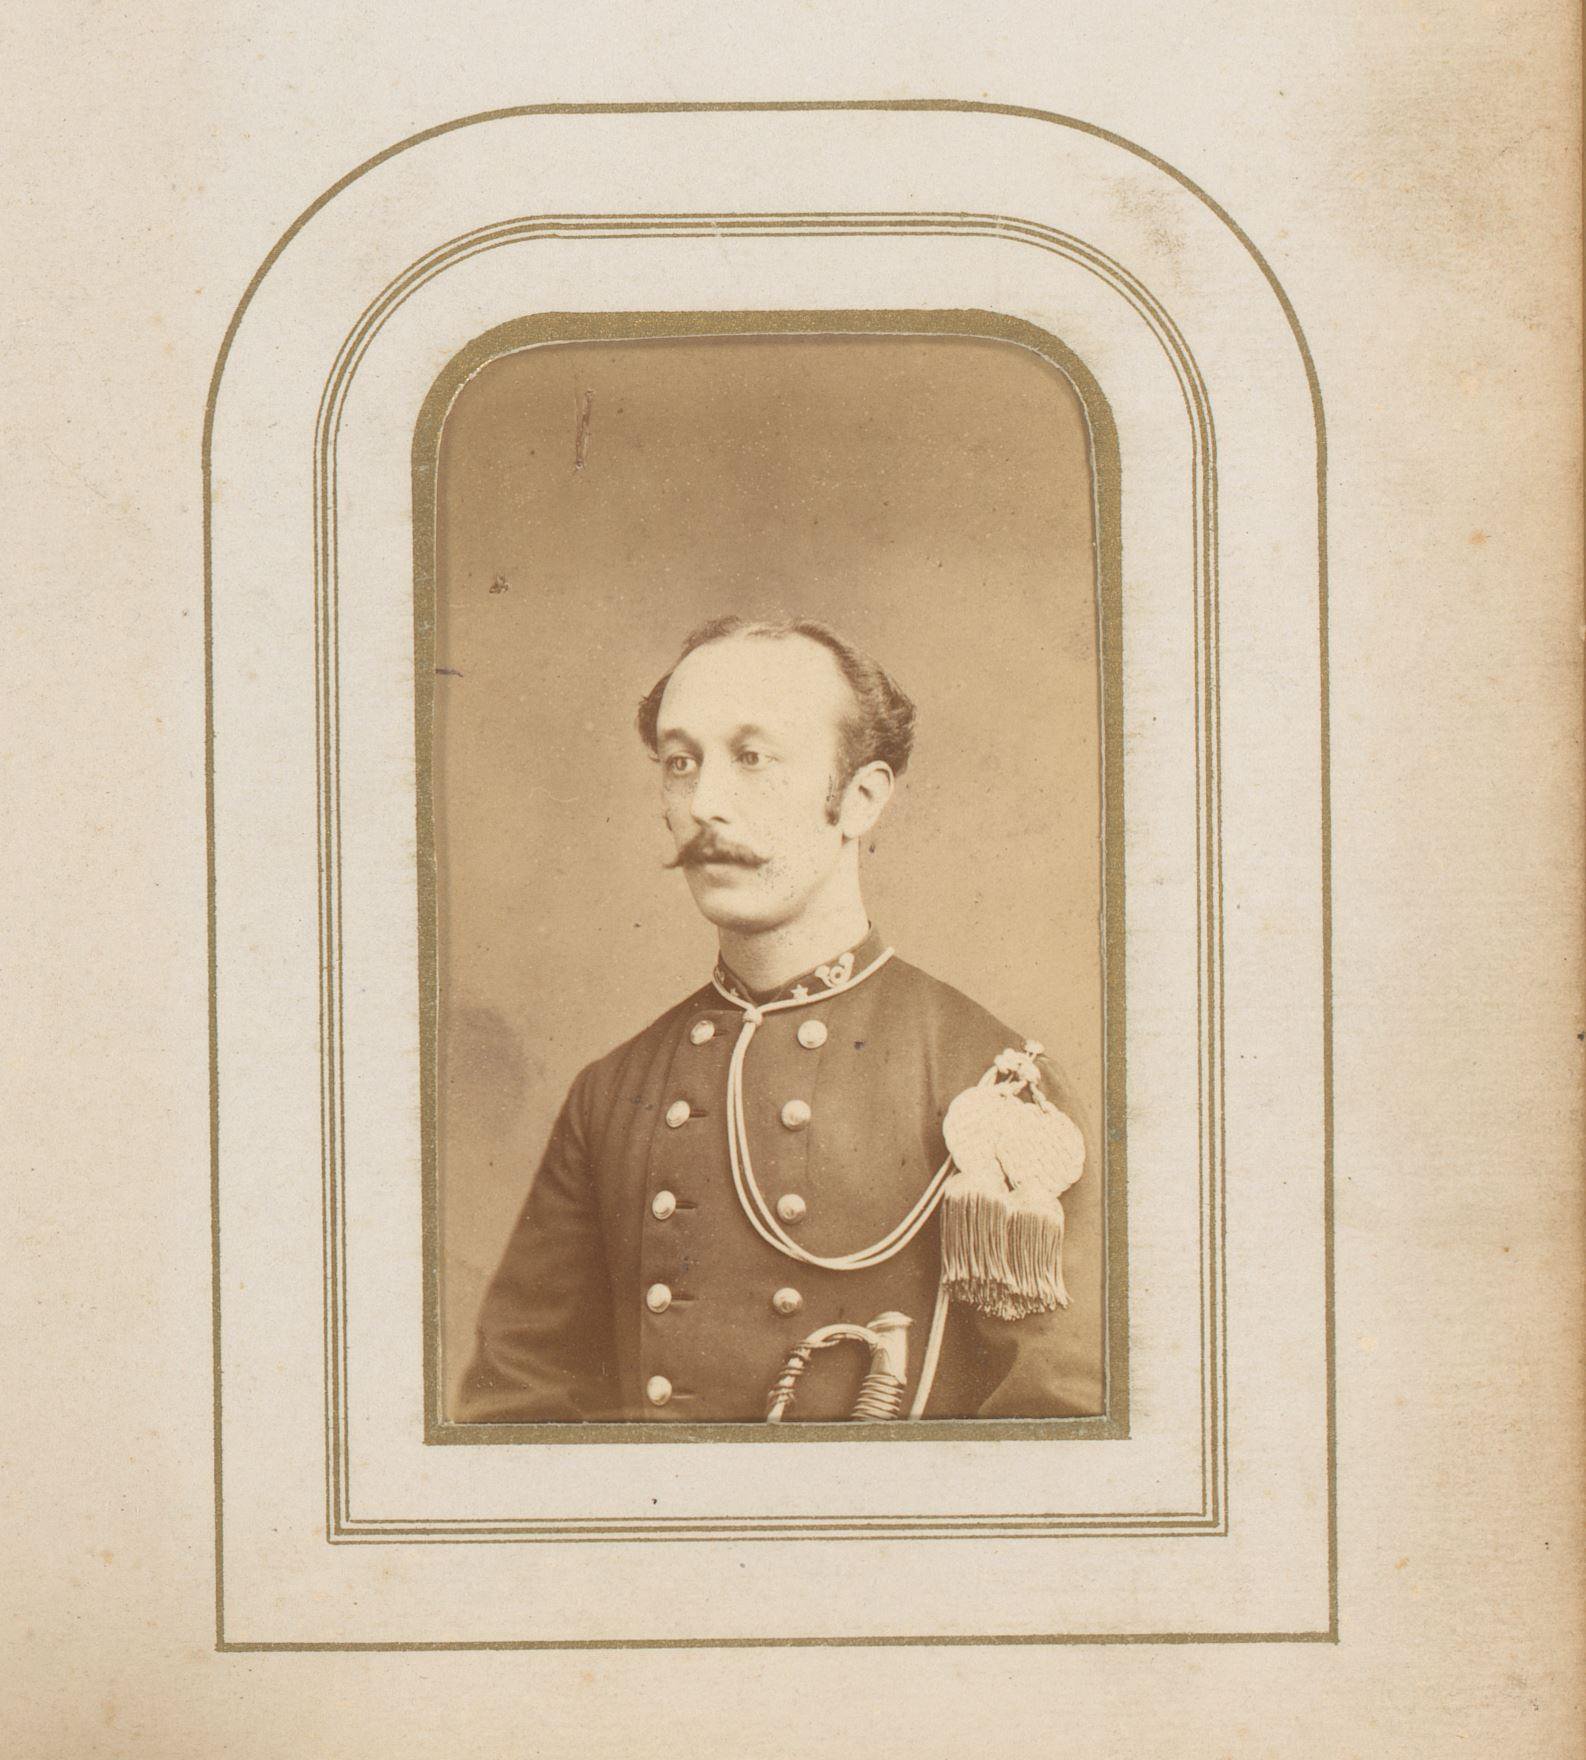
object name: album leaf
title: Portret van een man met snor in uniform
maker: Anonymous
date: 1860-1890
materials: cardboard, photographic support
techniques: albumen print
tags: moustache, historical persons, (military) uniforms